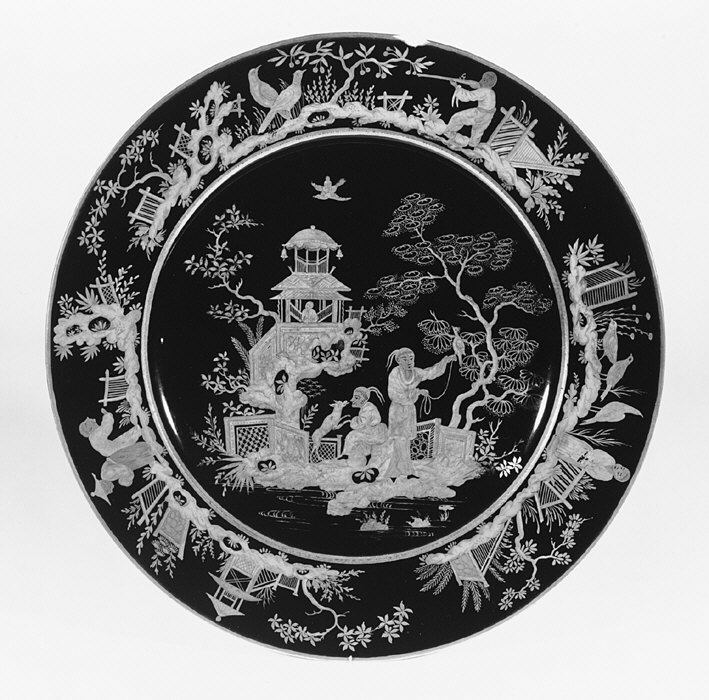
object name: plate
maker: sèvres manufactory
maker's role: manufactory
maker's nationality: french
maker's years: 1740-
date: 1791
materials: hard paste porcelain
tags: birds,chinoiserie,men,hunting